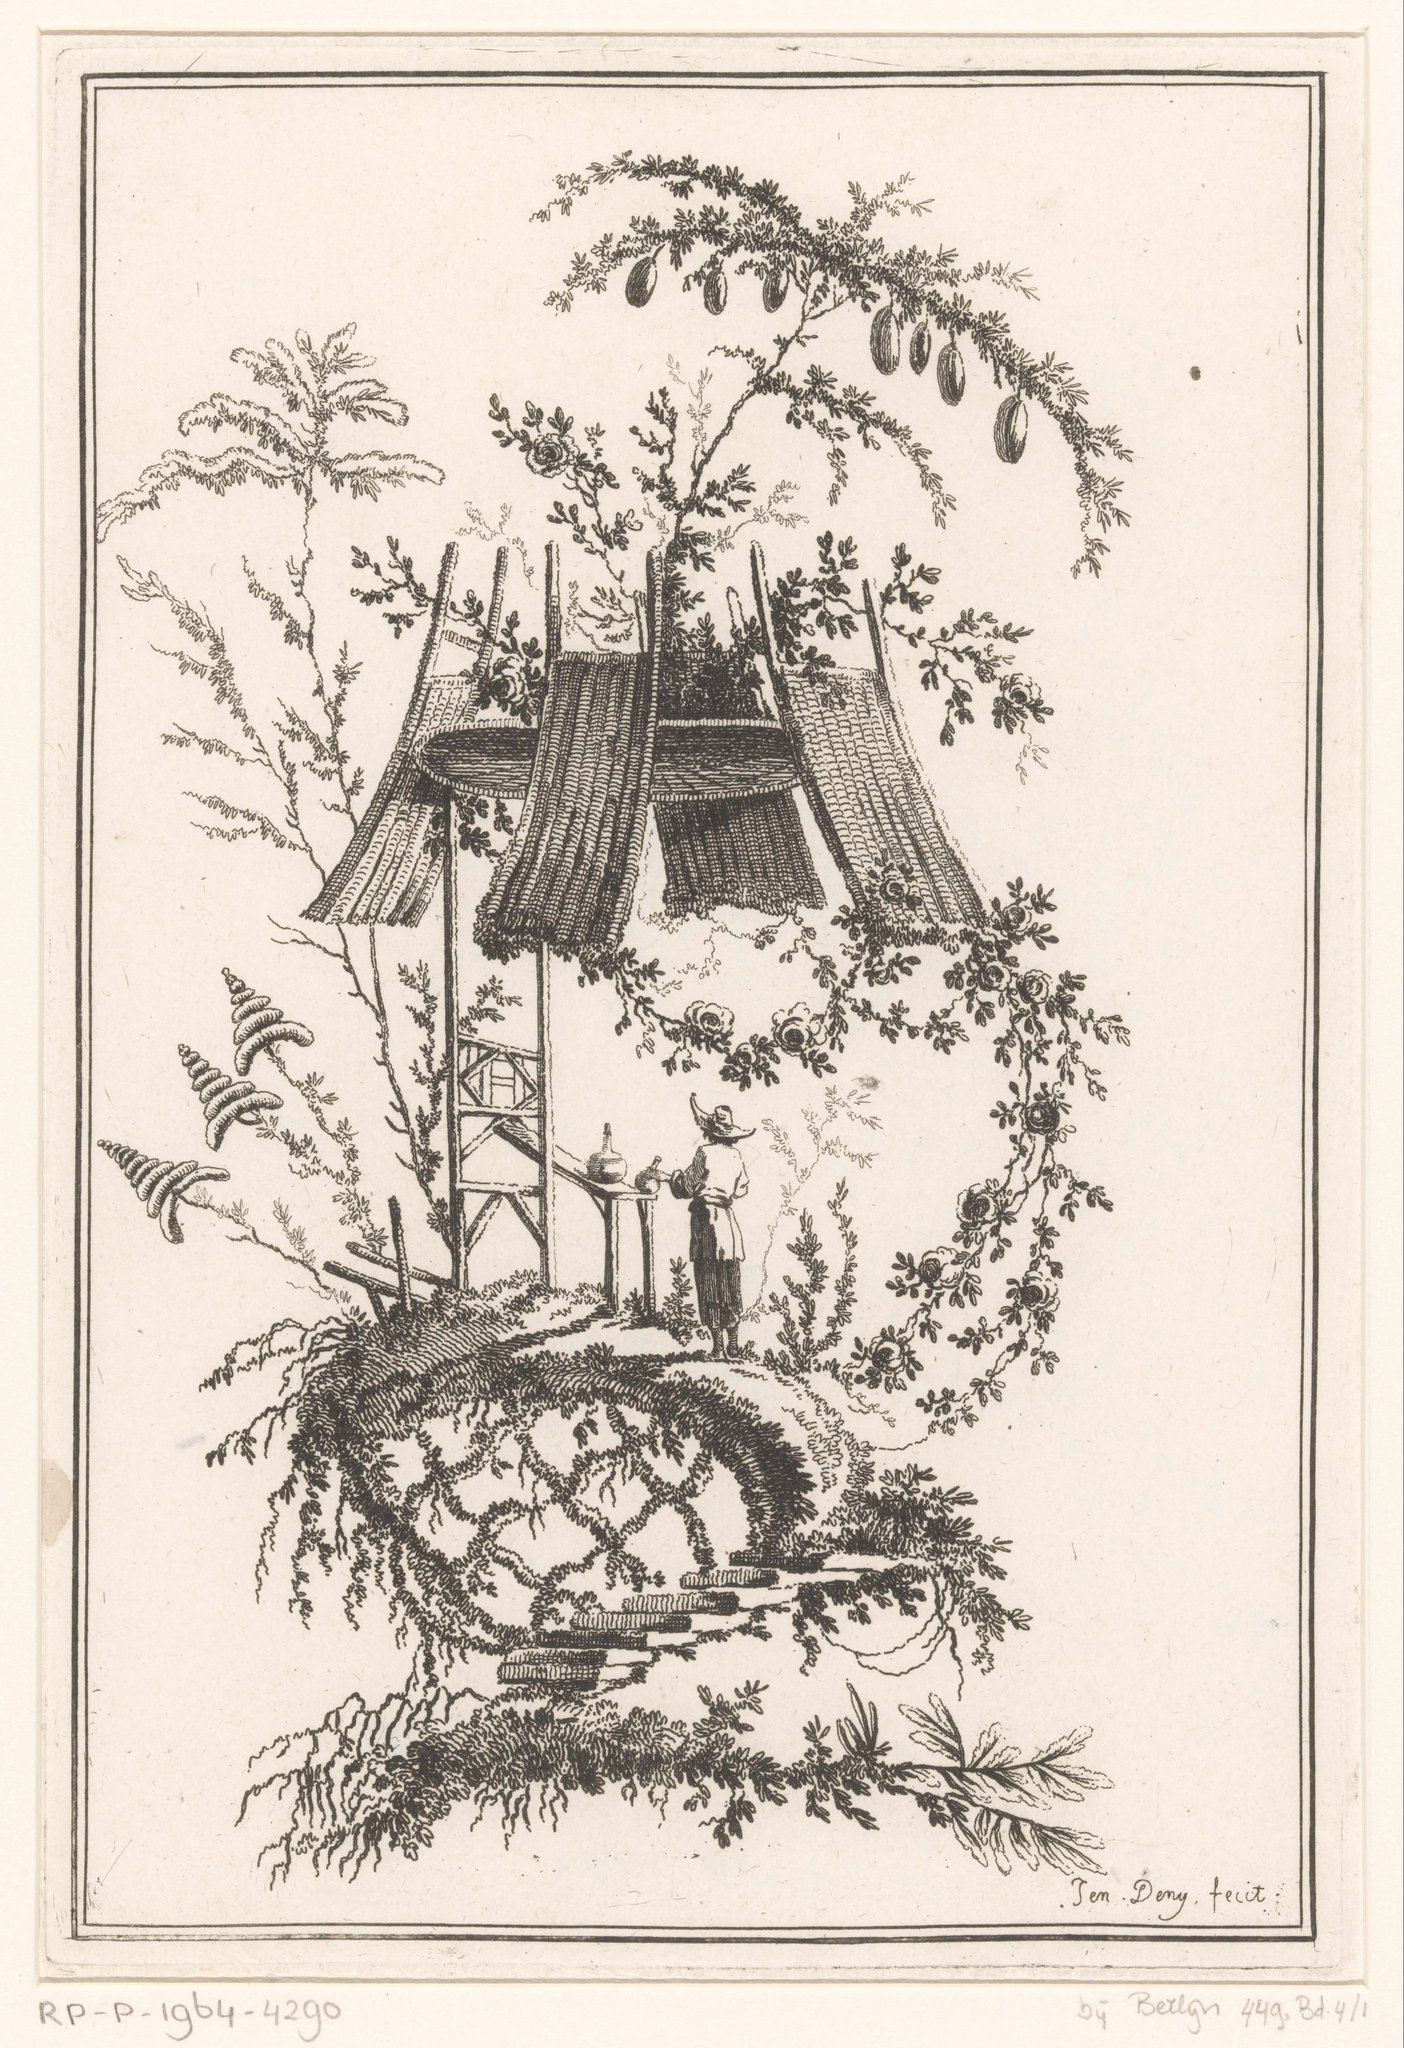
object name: ornament print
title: Cahier de six Baraques Chinoises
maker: jeanne deny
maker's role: print maker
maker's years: 1749-1836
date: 1772-1779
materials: paper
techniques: etching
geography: paris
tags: standing figure, container of glass: bottle, jar, vase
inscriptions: collector's mark: Lugt 2228, collector's mark: Lugt 2760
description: In een landschap onder luifels staat een man op de rug gezien. Hij zet flessen op een tafel.